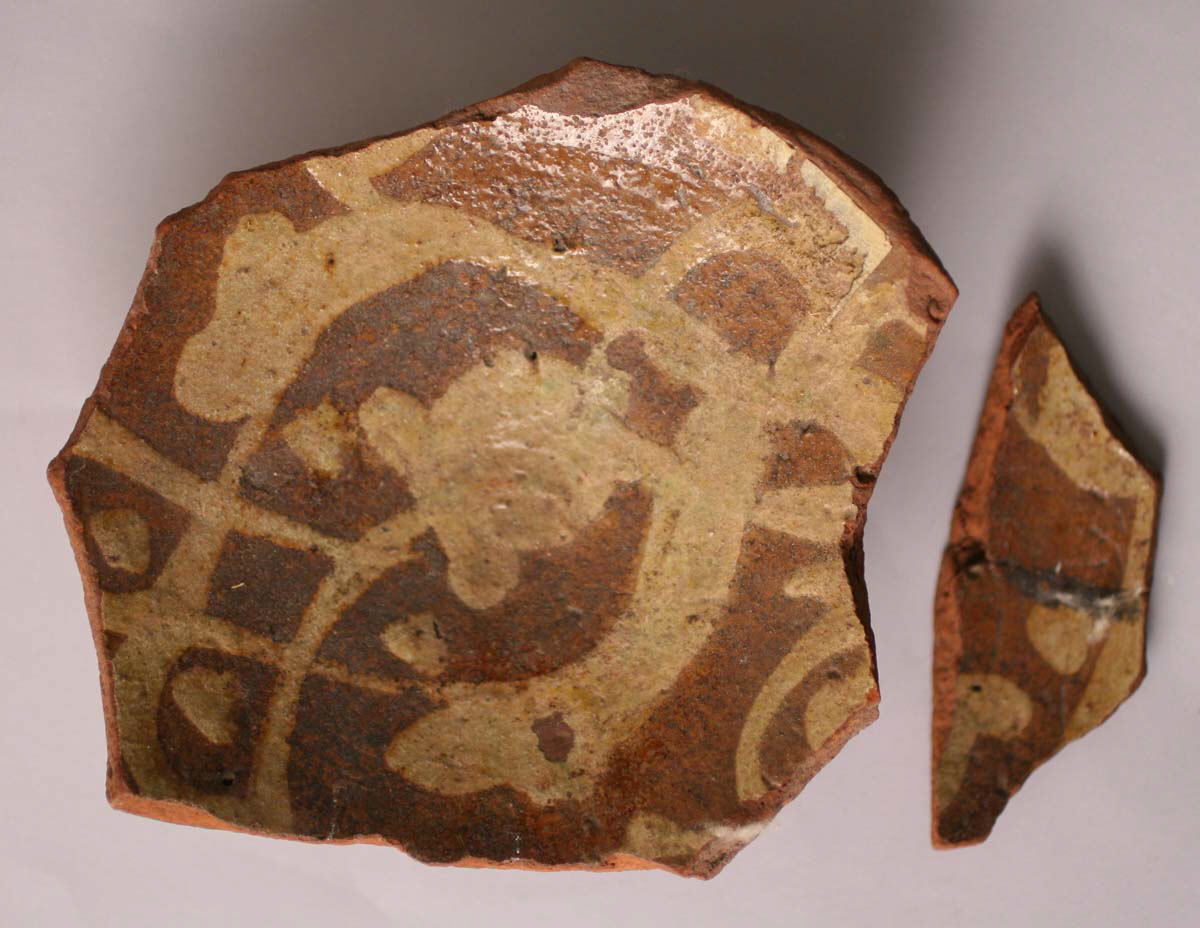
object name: fragment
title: Ceramic Fragments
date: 1301-1500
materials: earthenware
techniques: painting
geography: egypt